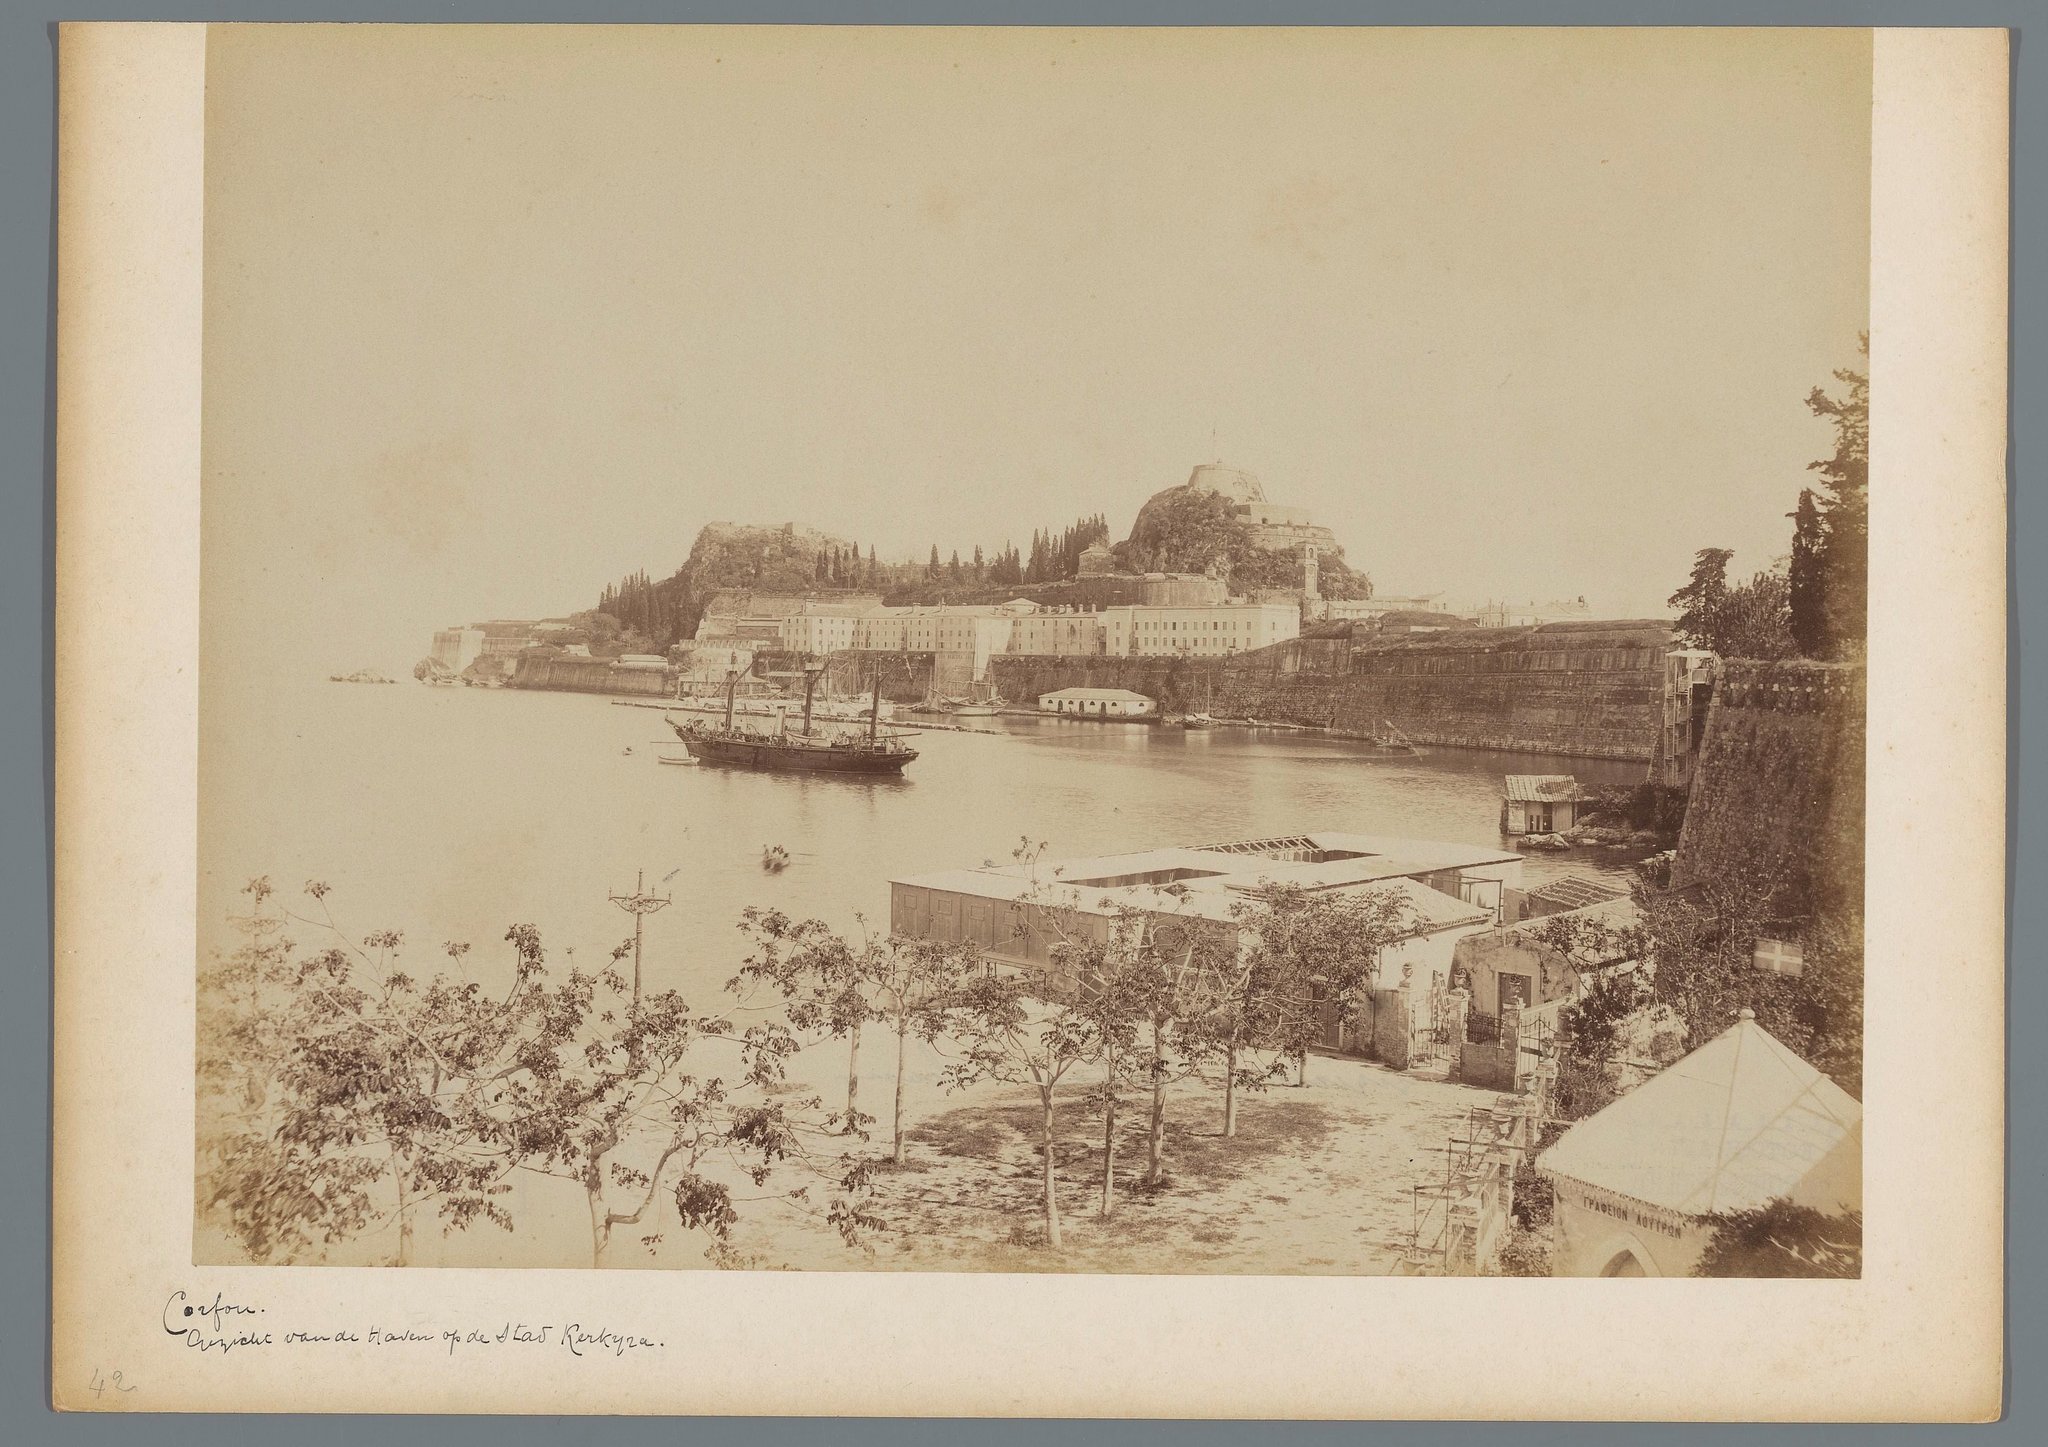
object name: photograph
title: Corfu, gezicht van de haven op de stad Kerkyra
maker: Anonymous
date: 1860-1900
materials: cardboard, paper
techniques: albumen print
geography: corfu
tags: harbour, fortress